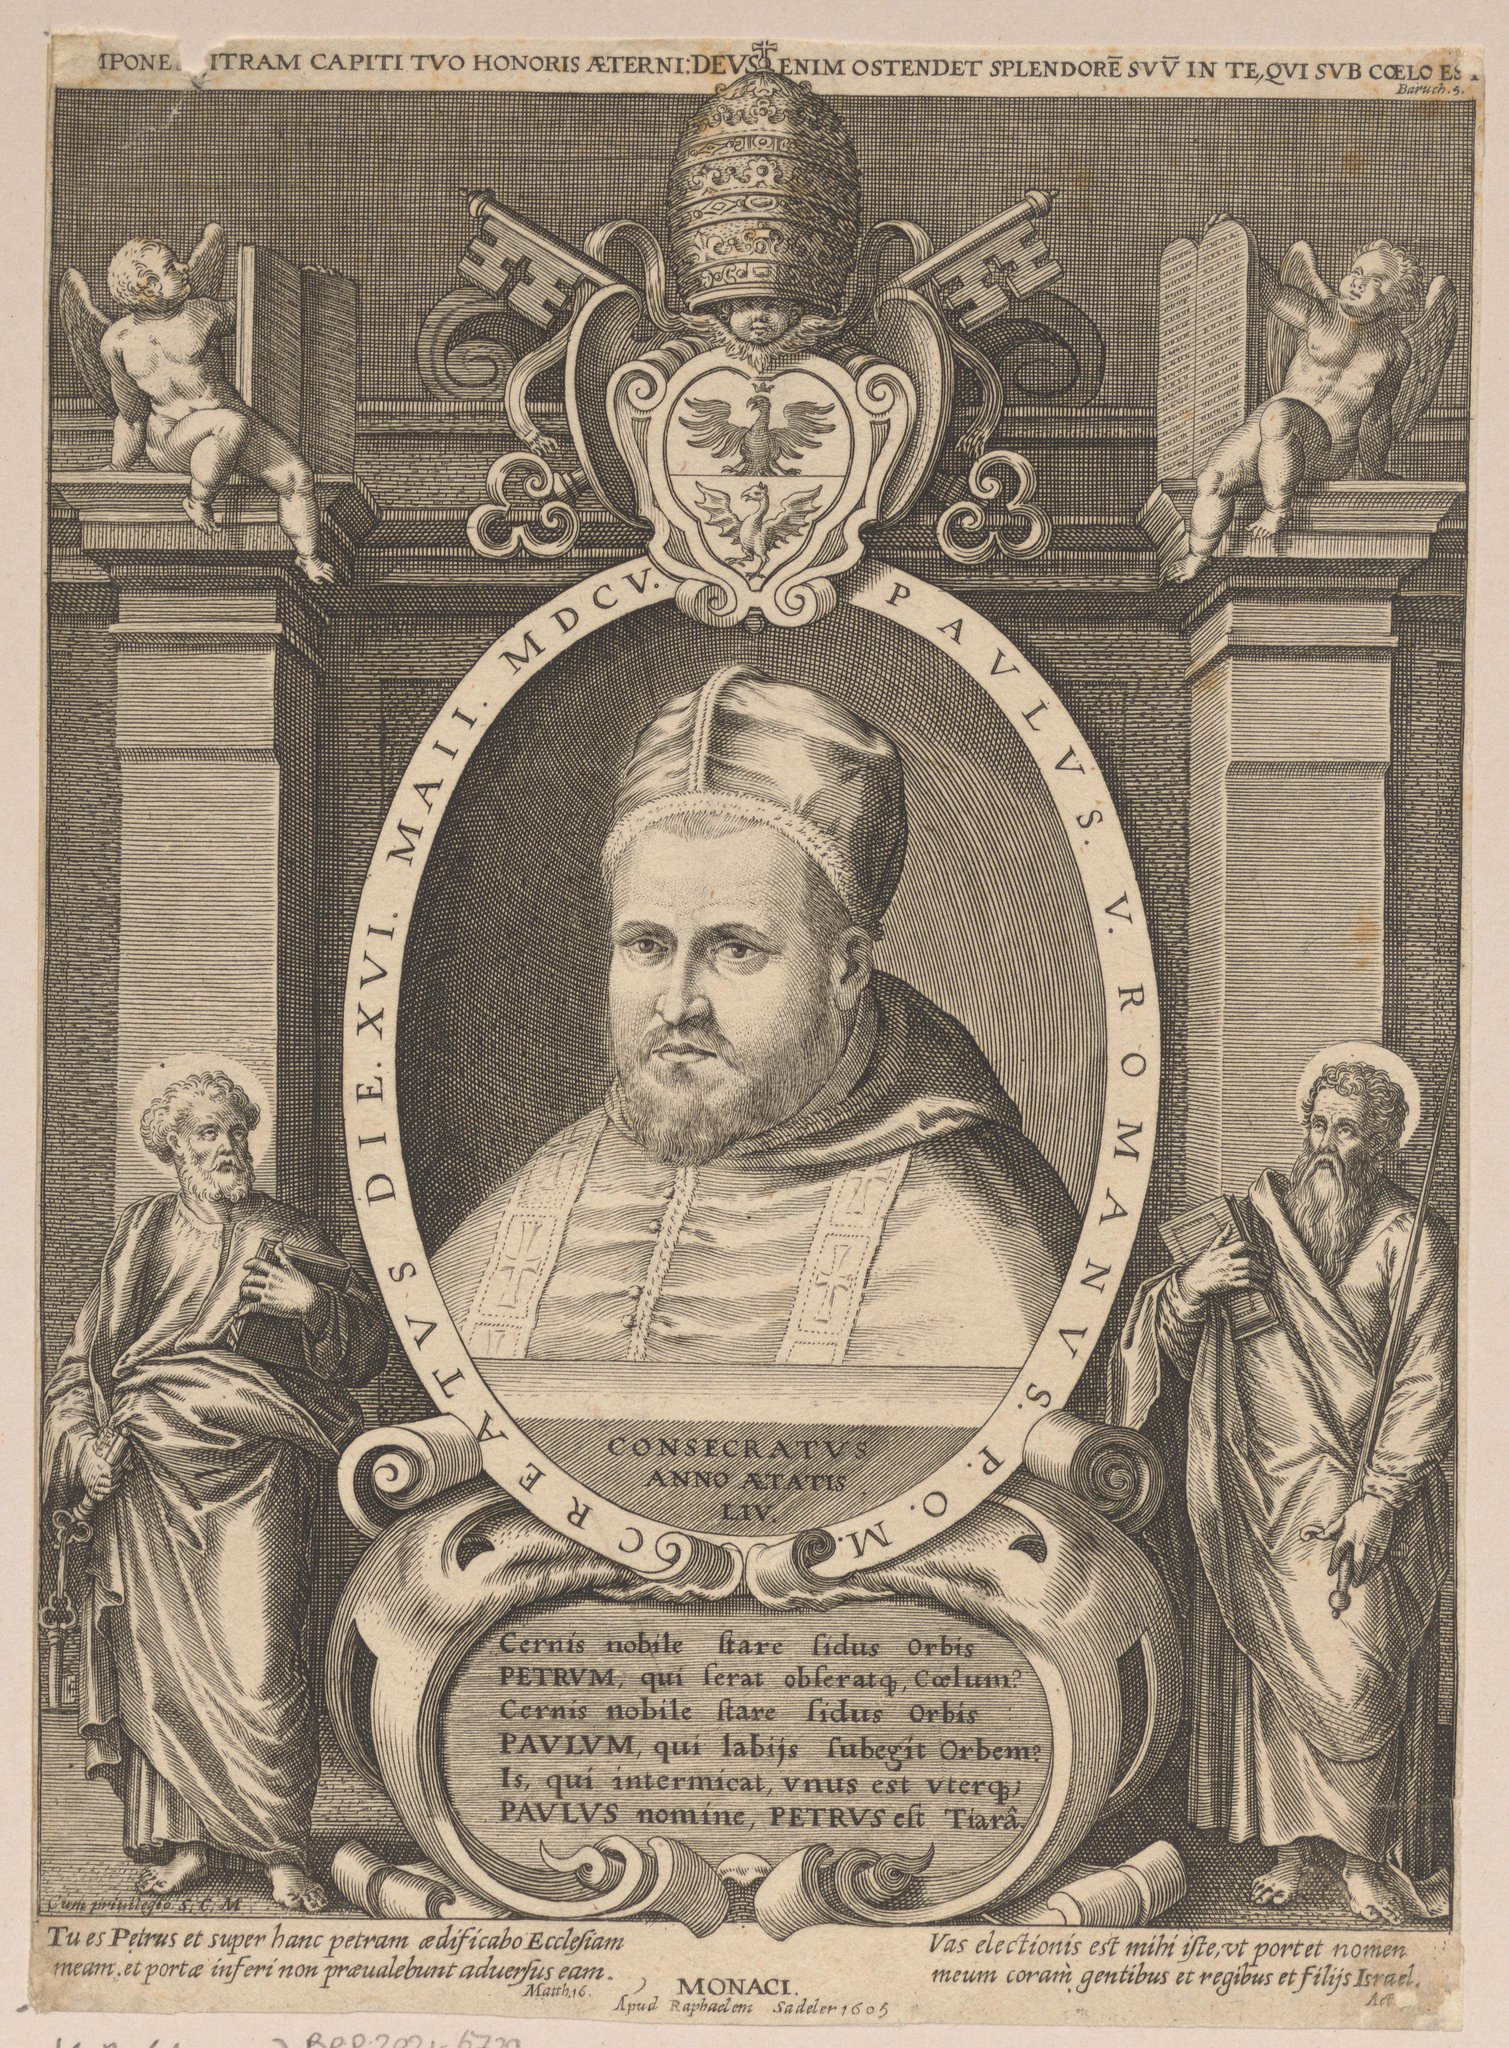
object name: print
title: Portret van paus Paulus V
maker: raphaël sadeler (i)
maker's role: print maker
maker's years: 1560-1628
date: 1605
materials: paper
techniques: engraving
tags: paulus v, historical persons, pope, the apostle peter, first bishop of rome; possible attributes: book, cock, (upturned) cross, (triple) crozier, fish, key, scroll, ship, tiara, armorial bearing, heraldry, the apostle paul of tarsus; possible attributes: book, scroll, sword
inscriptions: collector's mark: Lugt 240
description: Rechtsboven: Baruch 5. Links naast het portret is Petrus afgebeeld en rechts Paulus. Onderschrift in het Latijn.